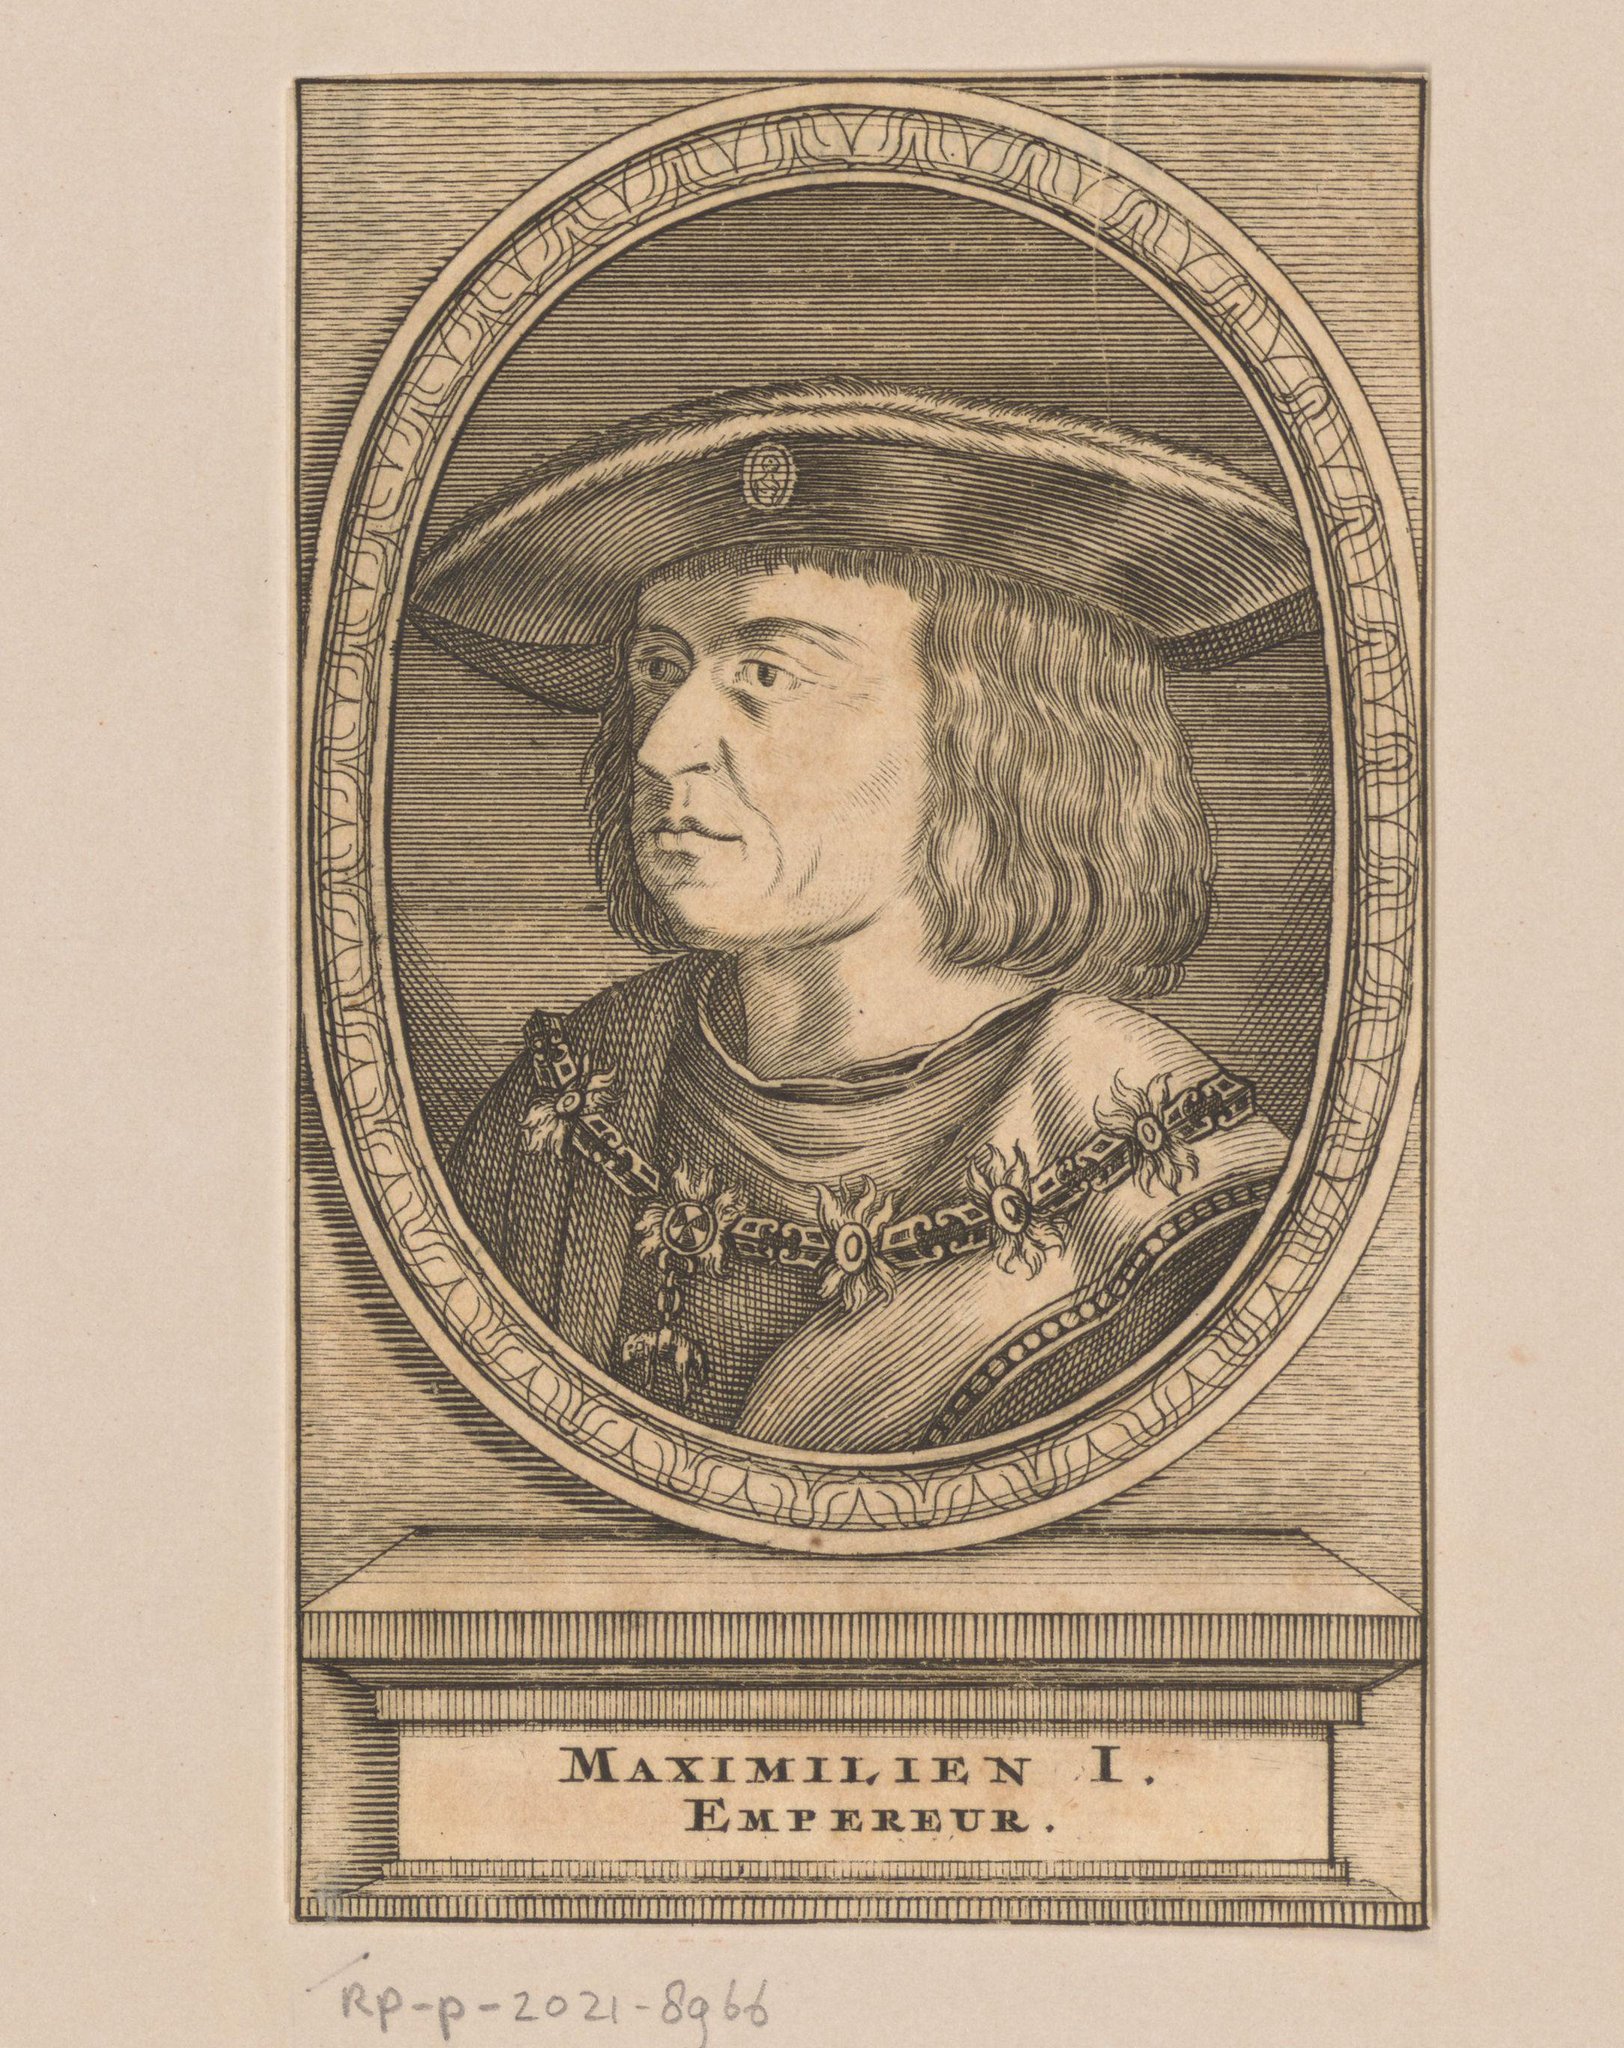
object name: print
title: Portret van keizer Maximiliaan I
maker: Anonymous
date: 1680-1750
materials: paper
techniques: engraving, etching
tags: maximilian i (holy roman emperor), ornament ~ medallion, historical persons, emperor, knighthood order of the golden fleece - insignia of a knighthood order, e.g.: badge, chain (with name of order)